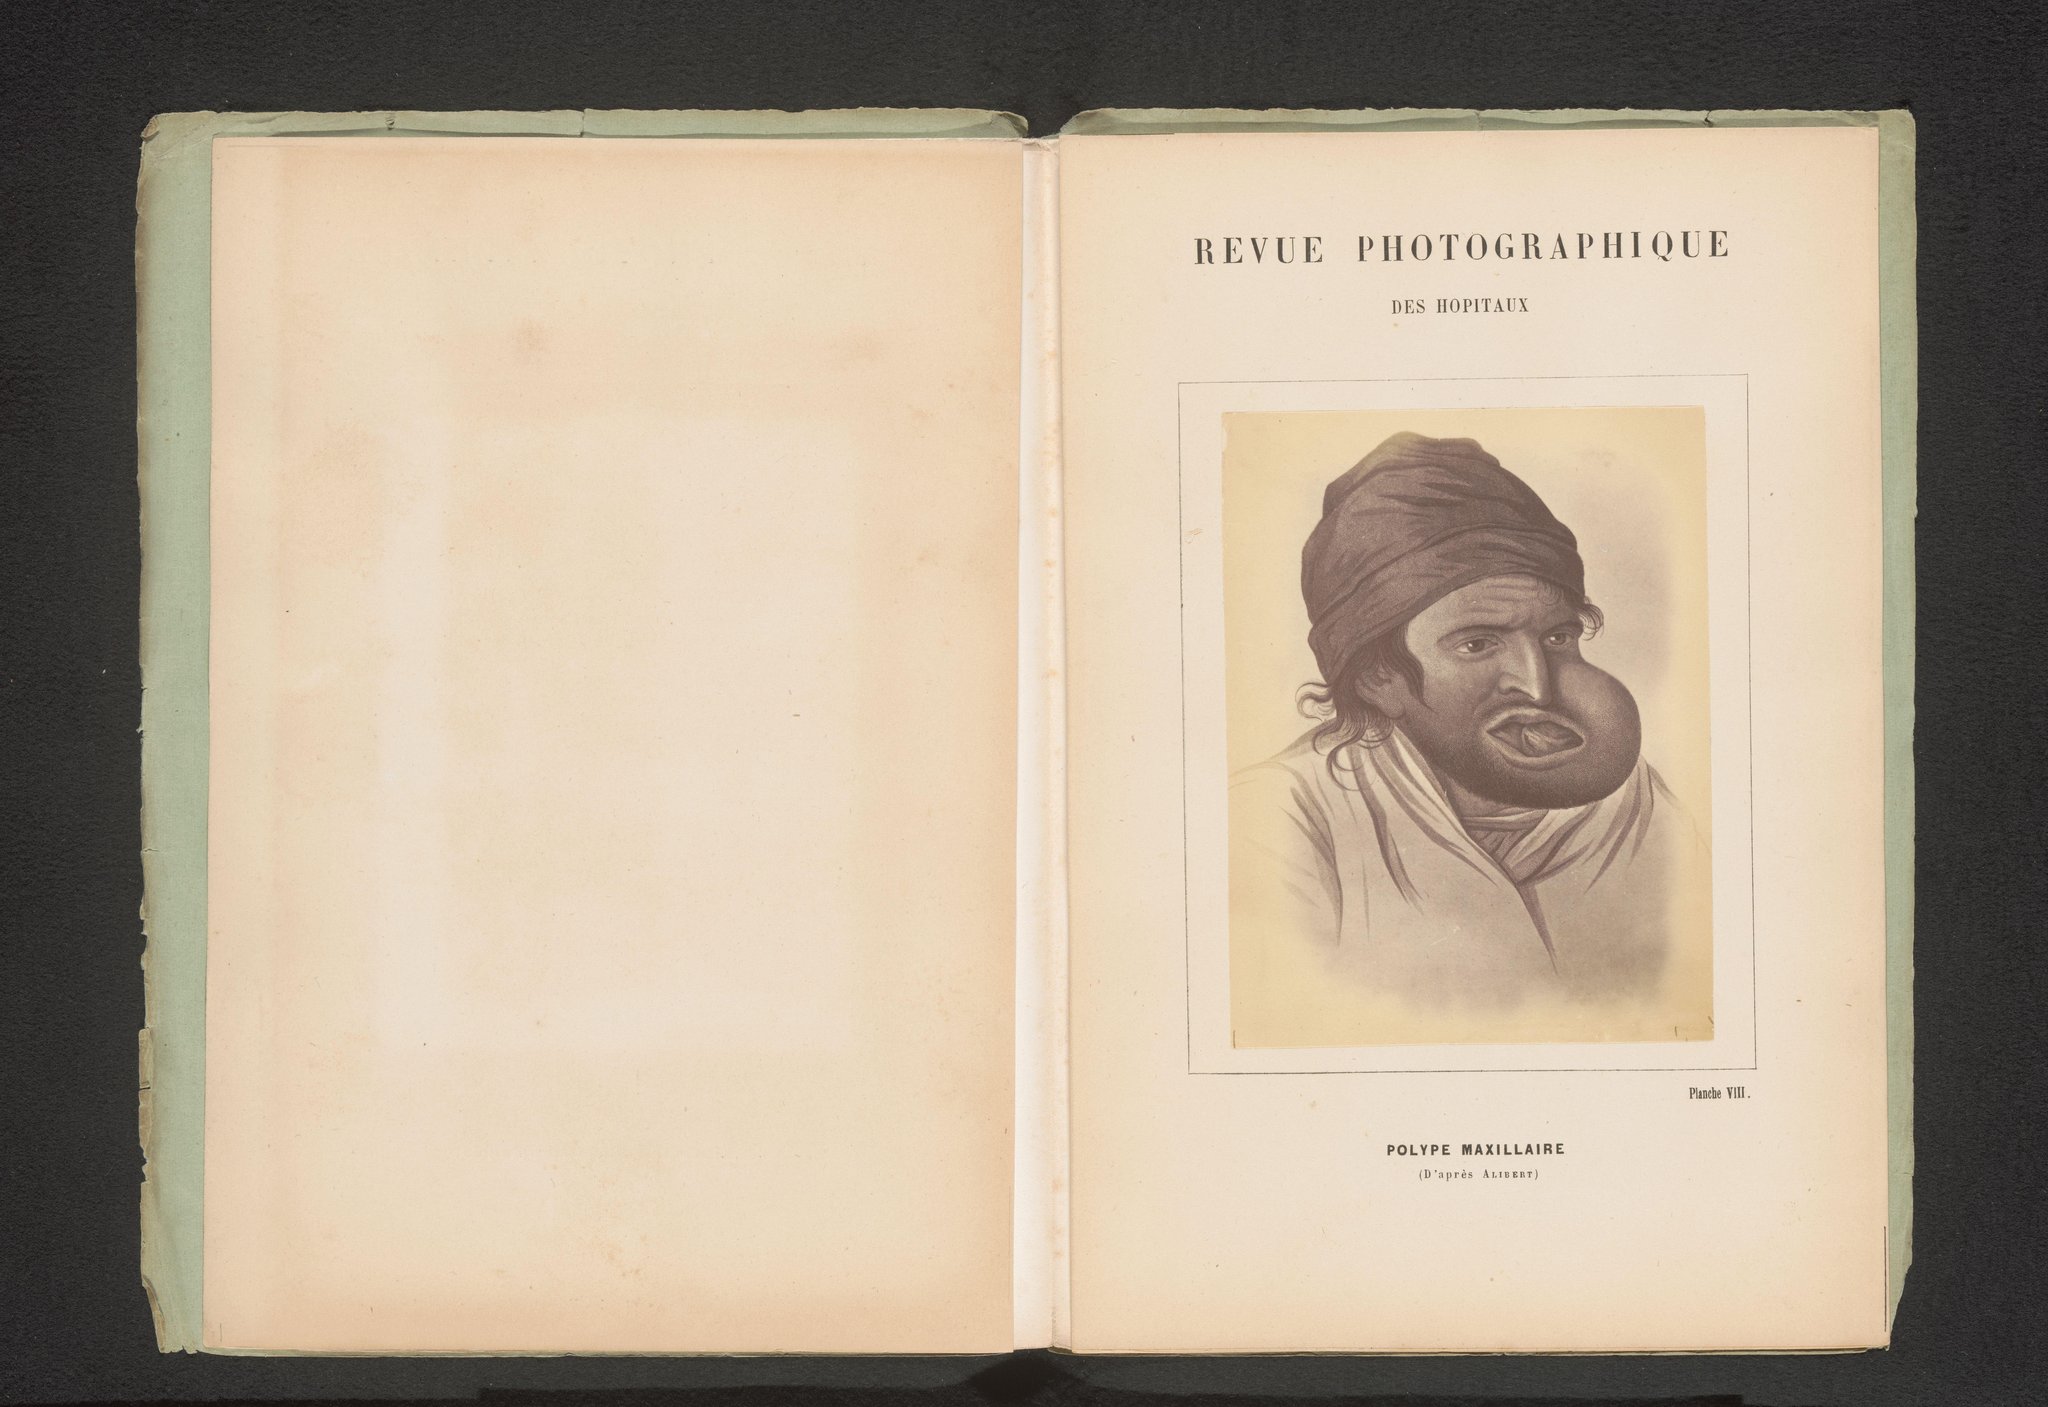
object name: reproduction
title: Polype maxillaire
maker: Anonymous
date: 1865-1870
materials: paper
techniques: albumen print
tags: tumours, medical research, branches of medicine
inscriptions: inscription: ‘Revue photographique/ des hopitaux/ Planche VIII.’